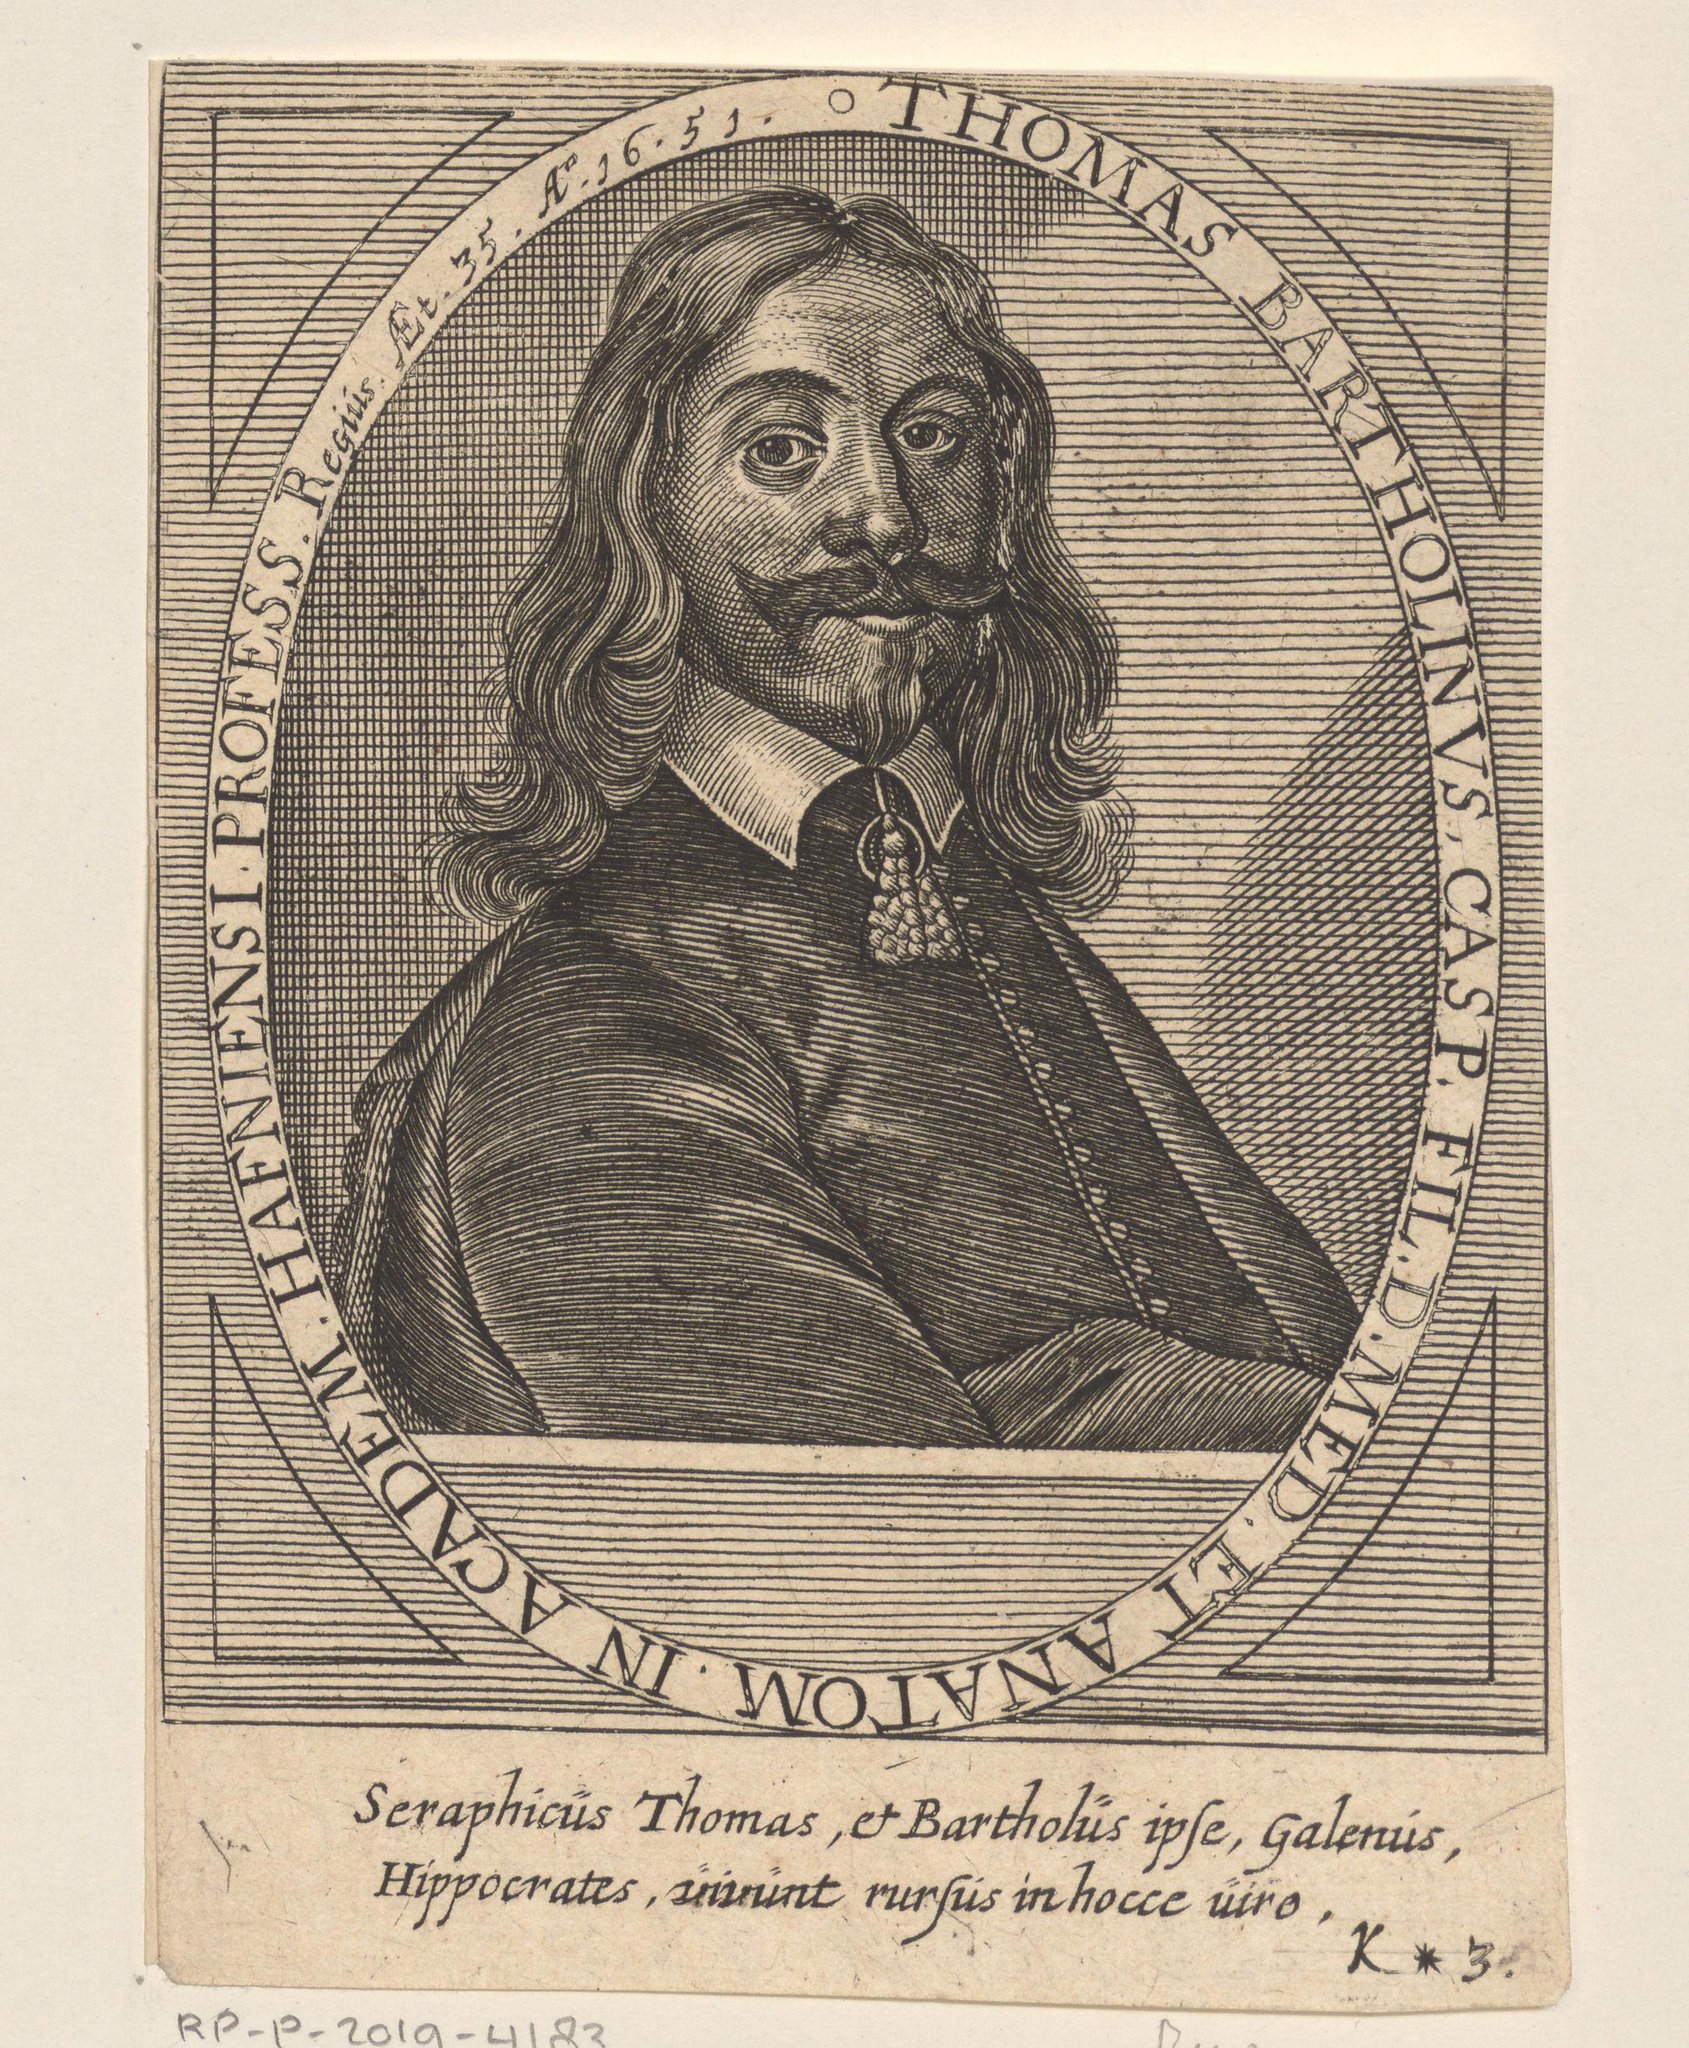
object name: print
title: Portret van Thomas Bartholin op 35-jarige leeftijd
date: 1651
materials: paper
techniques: engraving, etching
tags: copenhagen (city), thomas bartholin, historical persons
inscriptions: date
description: Prent mogelijk uit: Boissard, Jean Jacques. Bibliotheca chalcographica (...) VIII pars. Frankfurt am Main: Johannes Ammon, 1652.